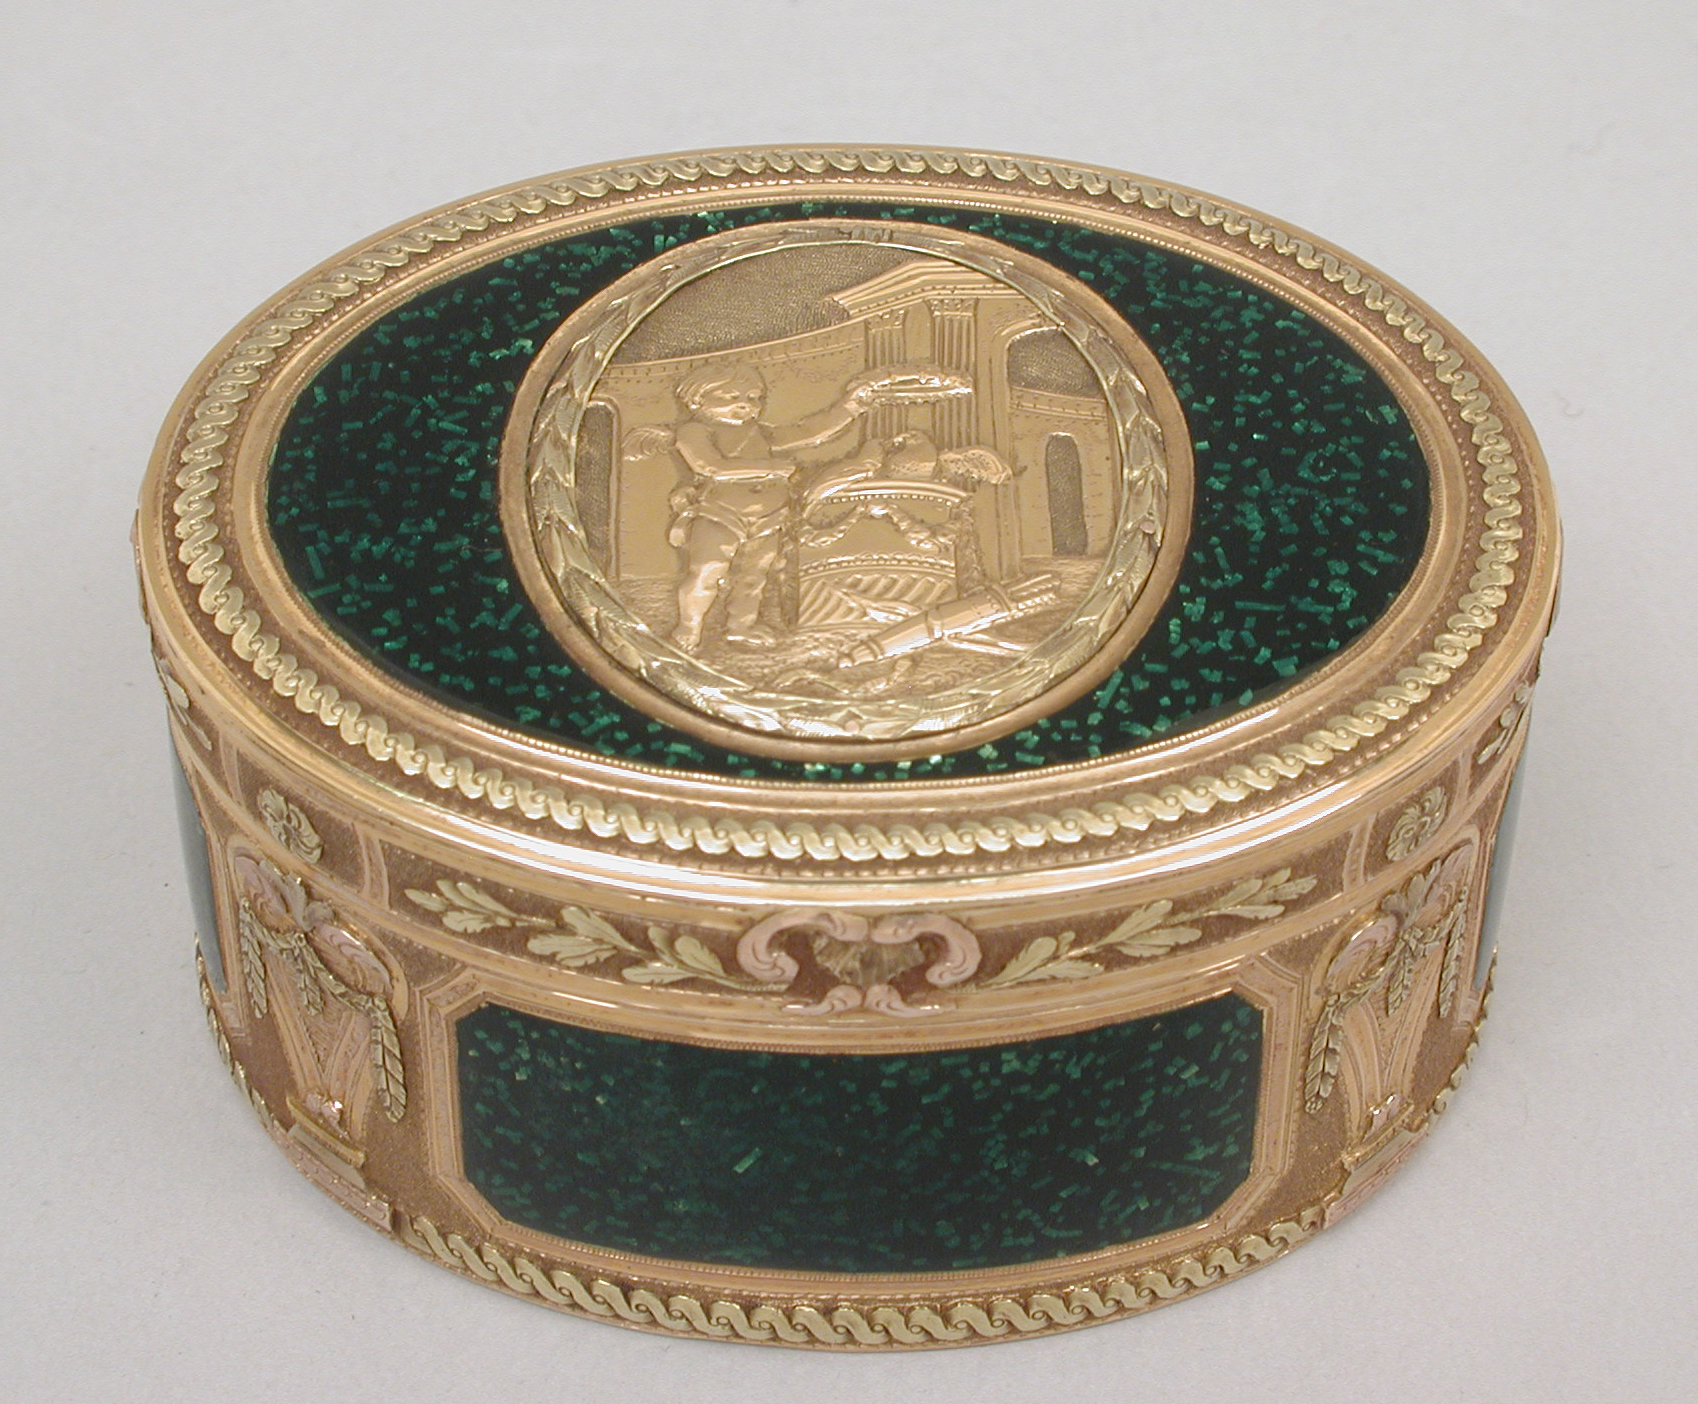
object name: snuffbox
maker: d.m.c., switzerland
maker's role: artist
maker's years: 1750-1800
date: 1780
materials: enamel, gold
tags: cupid